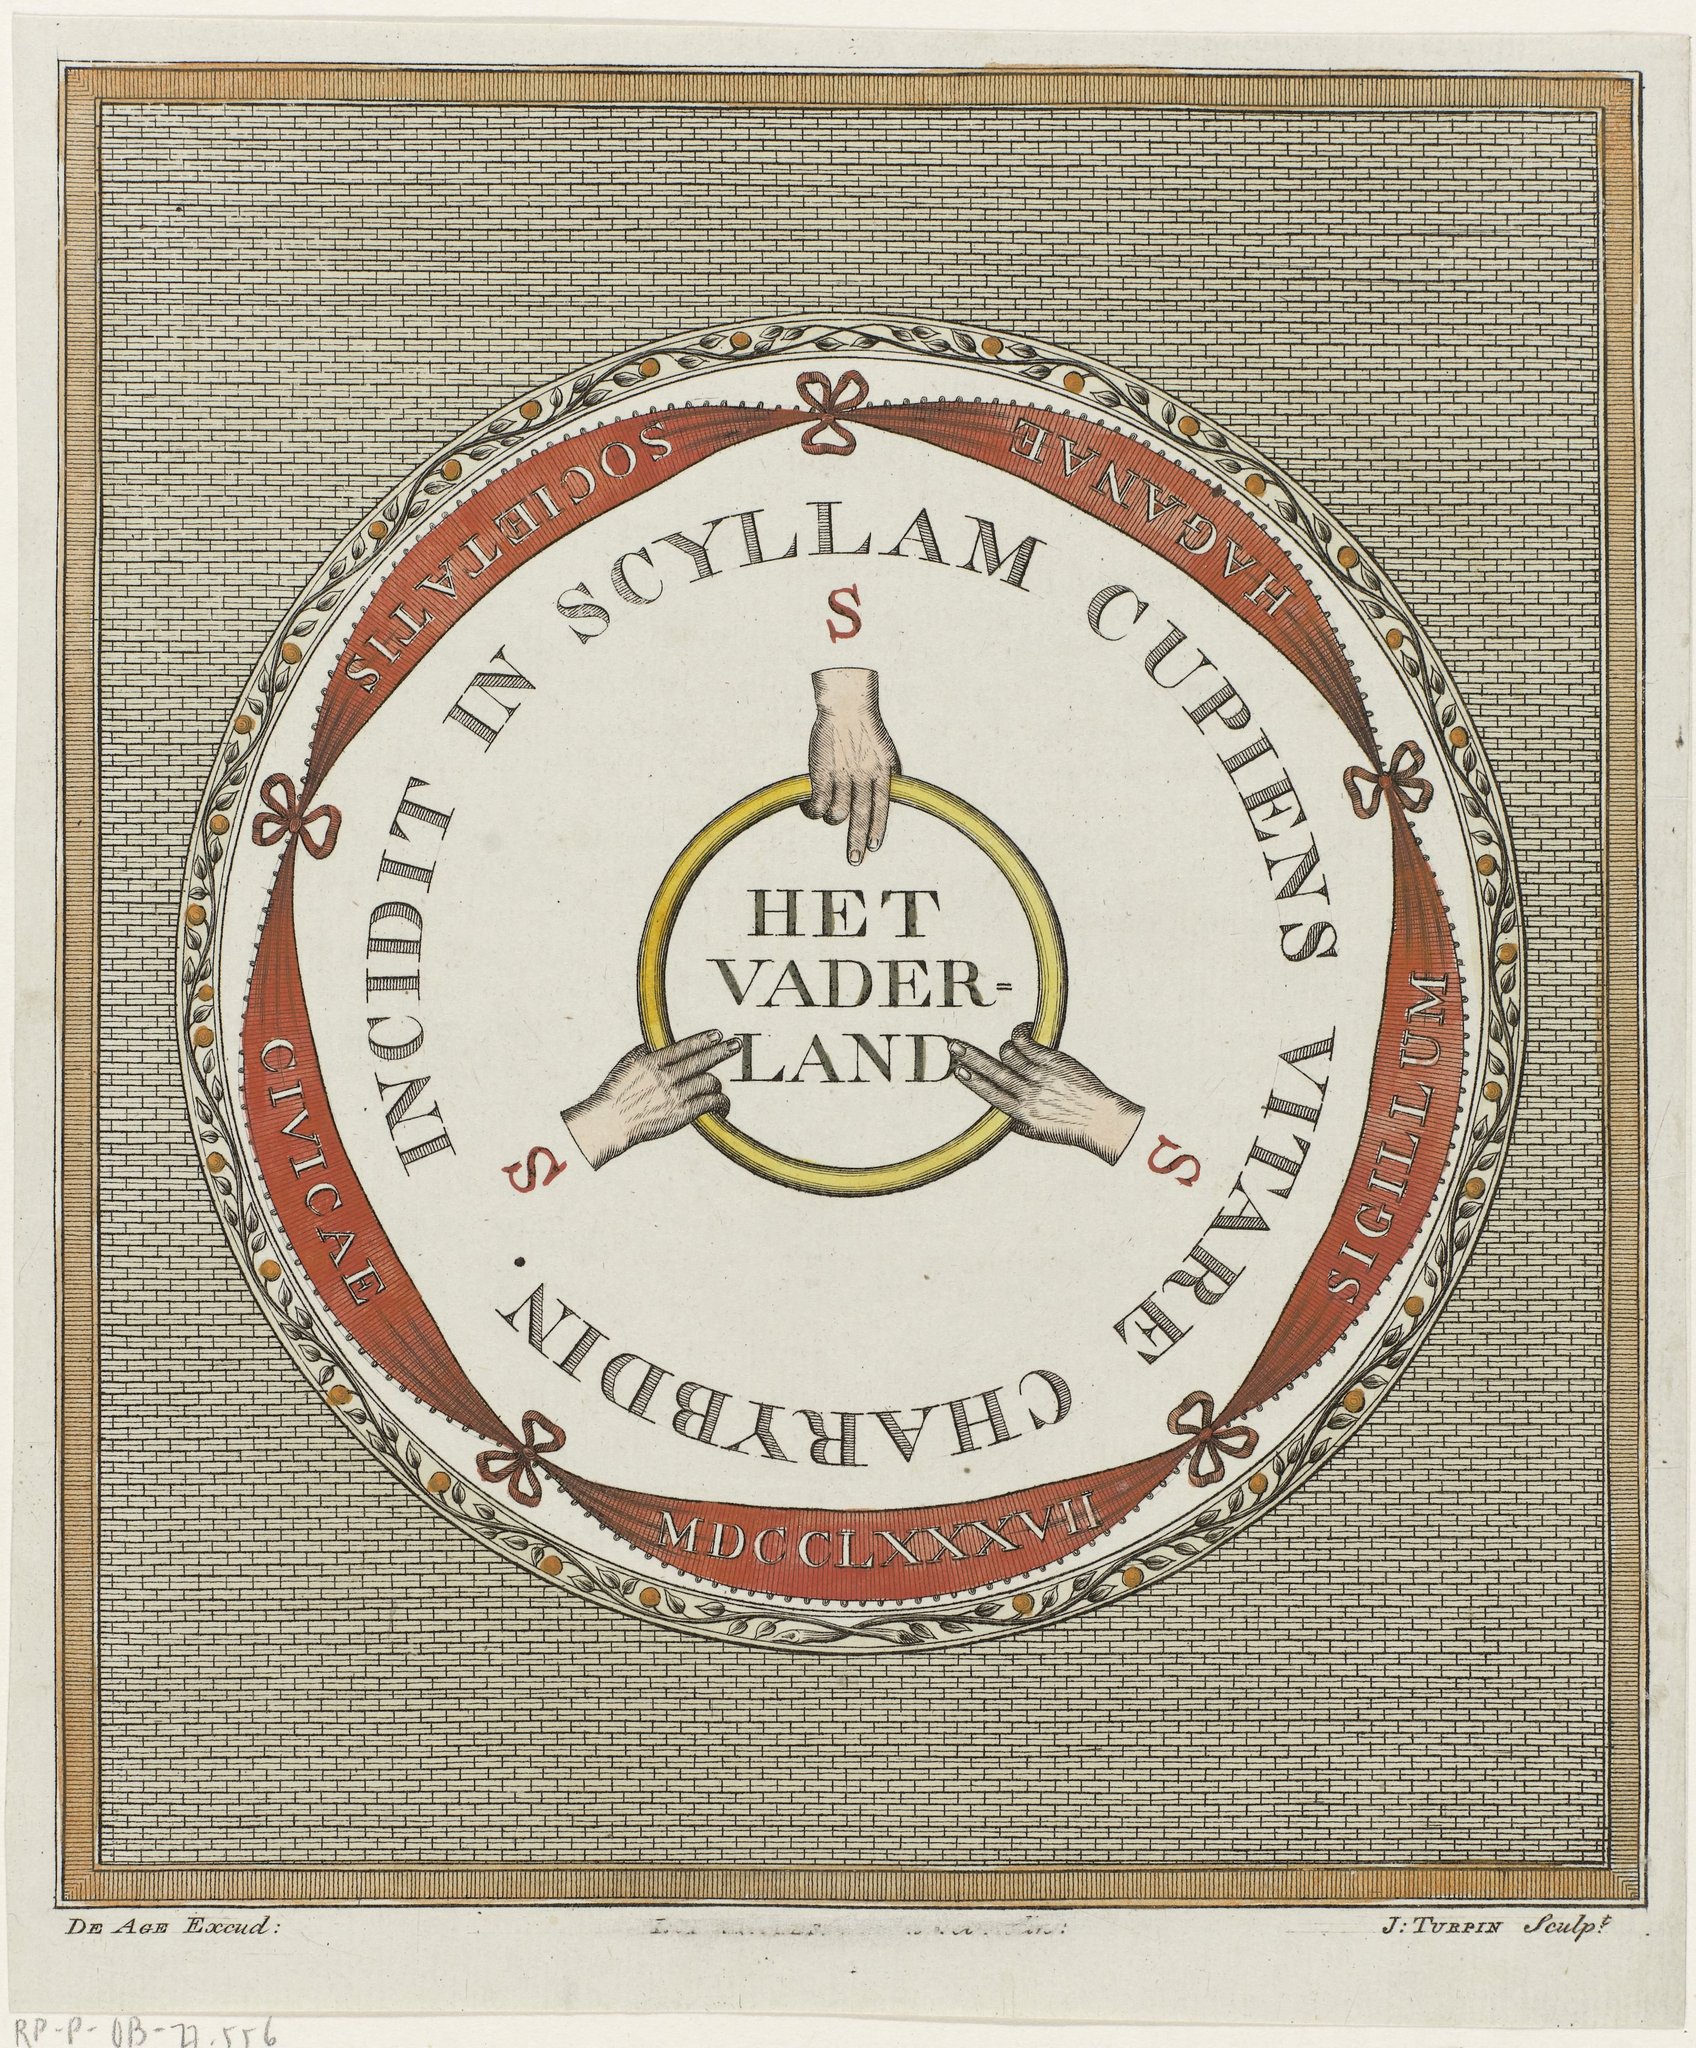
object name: print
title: Sigillum Haganae Societatis Civicae MDCCLXXXVII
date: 1787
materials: paper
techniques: engraving, etching, hand coloring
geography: the hague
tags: seal, stamp, seal (as symbol of the state, etc.), the hague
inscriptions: collector's mark: Lugt 2228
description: Zegel van het oranjegezinde genootschap Oprechte Vaderlandsche Sociëteit van Den Haag, opgericht op 10 april 1787. In het midden drie handen die een eed afleggen en een ring vasthouden. Hieromheen de motto van het genootschap: Incidit in Scyllam Cupiens Vitare Charybdin.